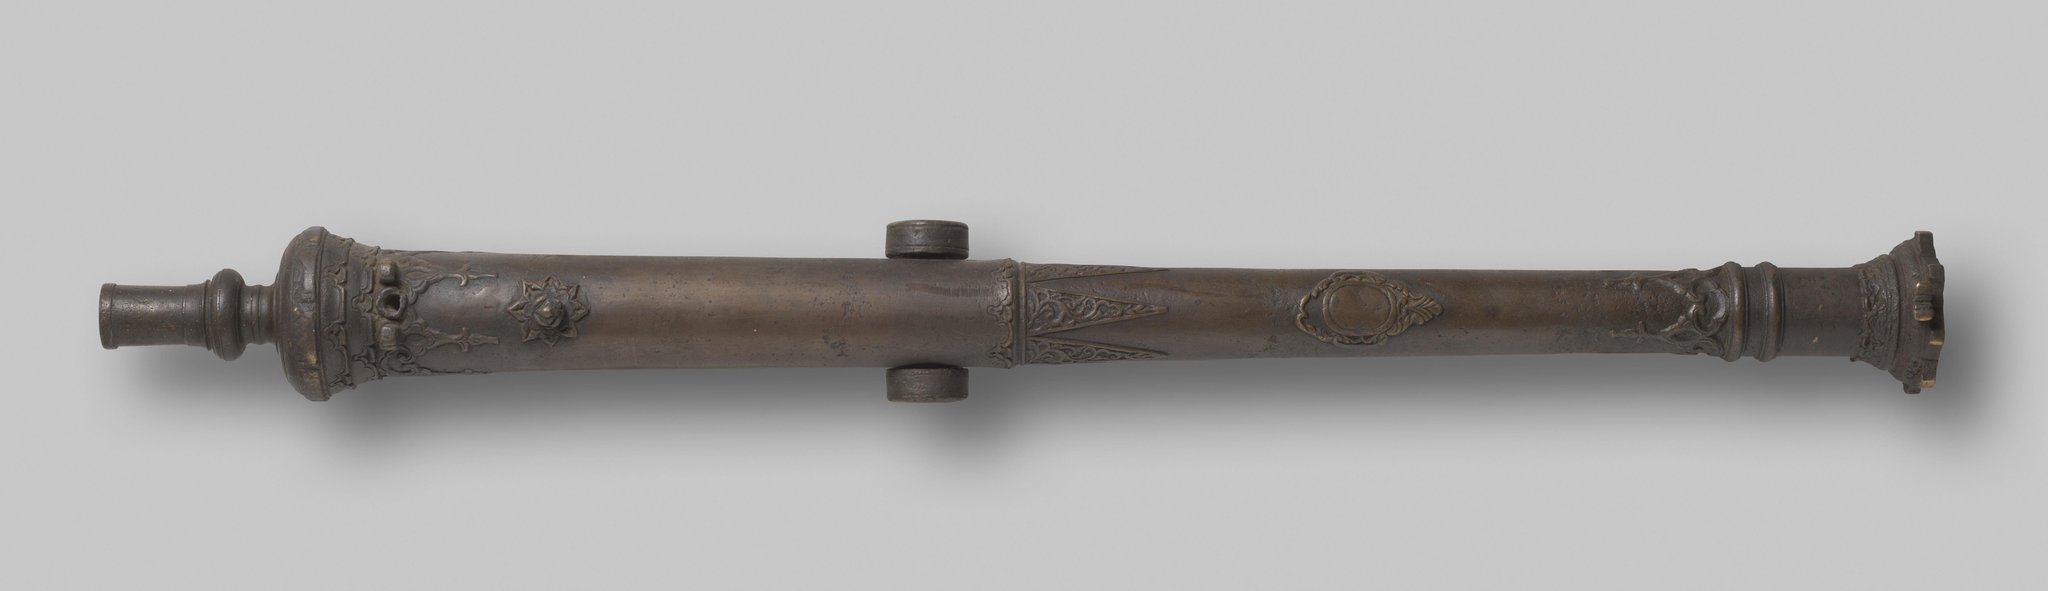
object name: lilla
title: Swivel Gun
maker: Anonymous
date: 1800-1856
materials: bronze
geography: borneo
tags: tanjung pulisan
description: Deze lilla of draaibas met een loop van Borneo's maaksel is in april 1856 door Zr. Ms. stoomschip Amsterdam nabij Tanjung Pulisan op de noordoostkust van Celebes op zeerovers veroverd.